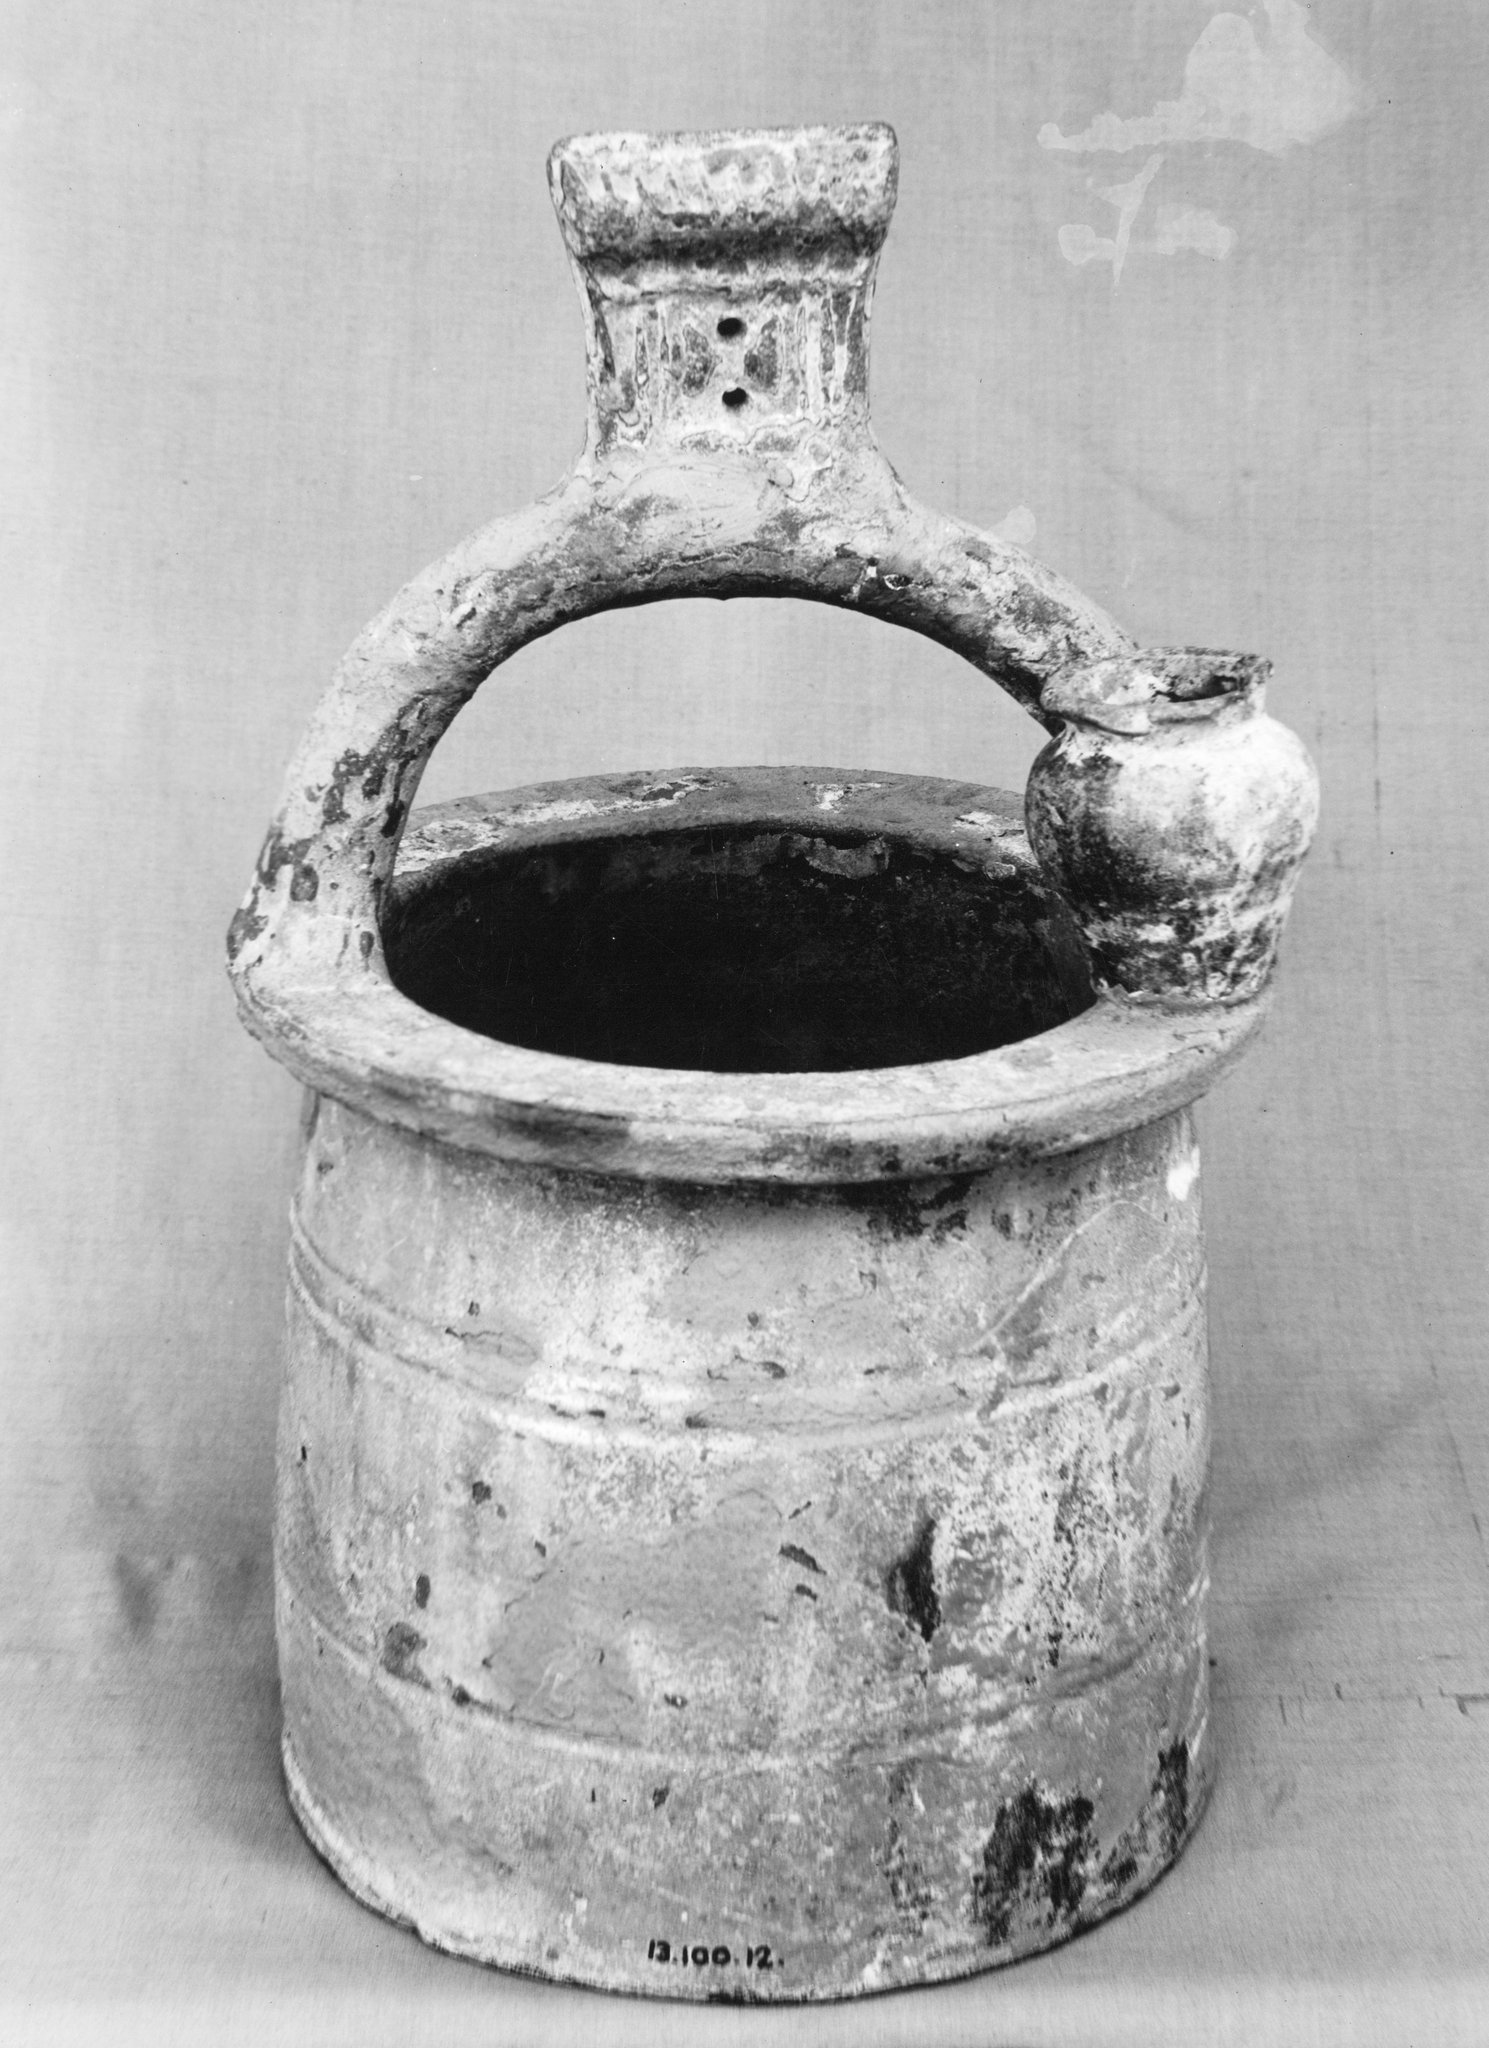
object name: model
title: Model of a well head and bucket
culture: chinese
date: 1-200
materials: earthenware, glaze, lead